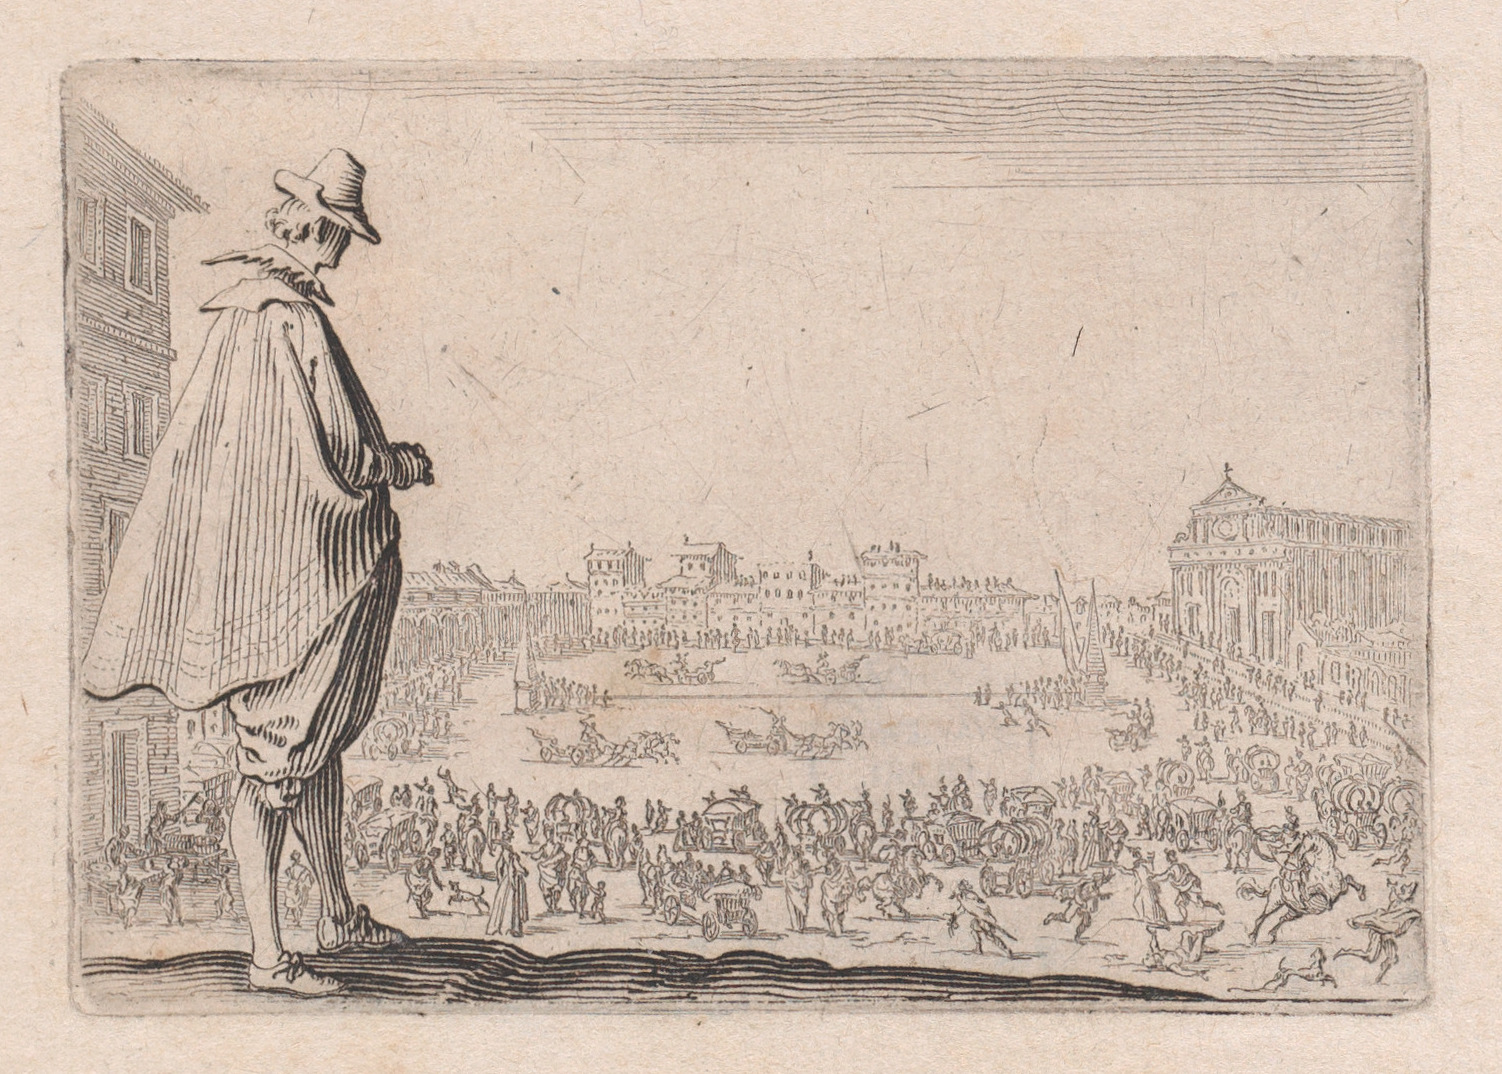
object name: print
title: La Course de Chars sur la Place Santa Maria Novella a Florence (The Chariot Race on the Piazza Santa Maria Novella in Florence), from "Les Caprices" Series B, The Nancy Set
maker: jacques callot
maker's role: artist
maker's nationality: french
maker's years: 1592-1635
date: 1617-1620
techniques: etching